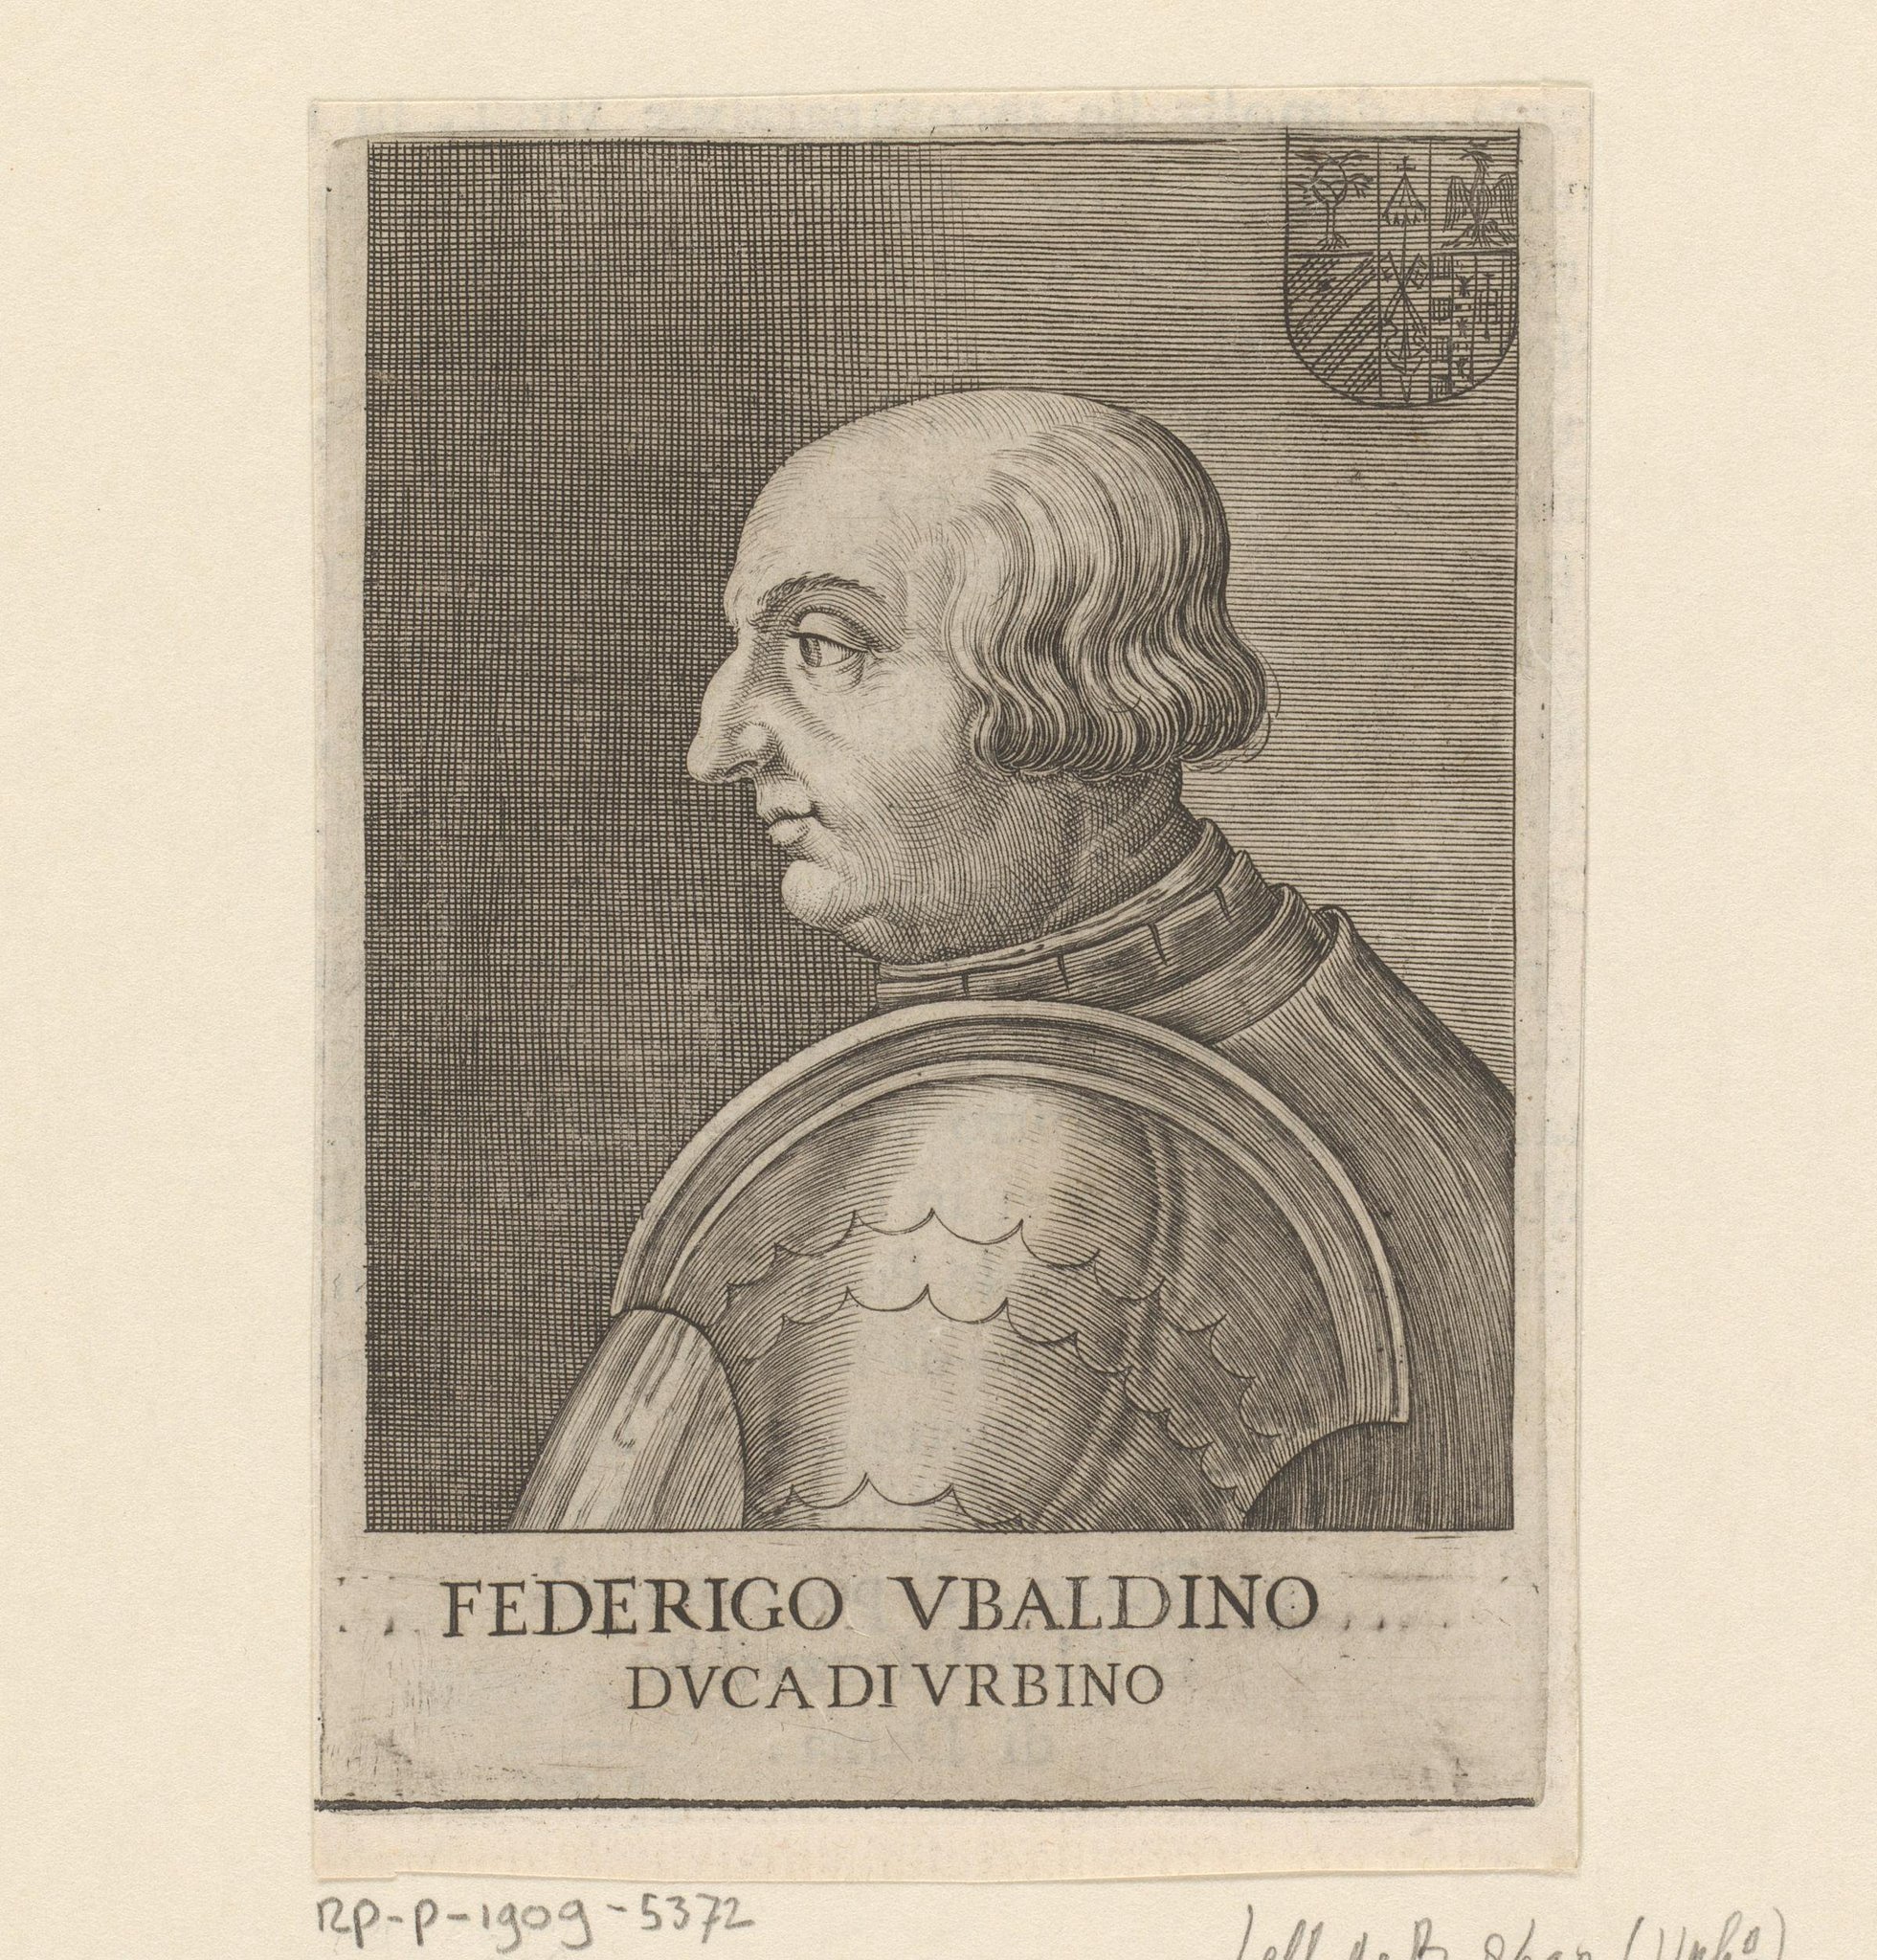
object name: print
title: Portret van Federico da Montefeltro, hertog van Urbino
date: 1646-1647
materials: paper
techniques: engraving, letterpress printing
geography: rome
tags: historical persons, ruler, sovereign, armorial bearing, heraldry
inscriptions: collector's mark: Lugt 2228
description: Prent uit: Ritratti et elogii di capitani Illustri. Che ne'secoli moderni hanno gloriosamente guerreggiato. Rome: Filippo de'Rossi en Vitale Mascardi, 1646, p. 154. Prent ook gebruikt in dezelfde editie van 1647. Eerdere staten van prent in ieder geval gebruikt in: Ritratti et elogii di capitani Illustri. Rome: Pompilio Totti en Andrea Fei, 1635. En in: Ritratti di cento capitani illustri con li lor Fatti in guerra (…), Rome: Domenico Gigliotti, 1596.